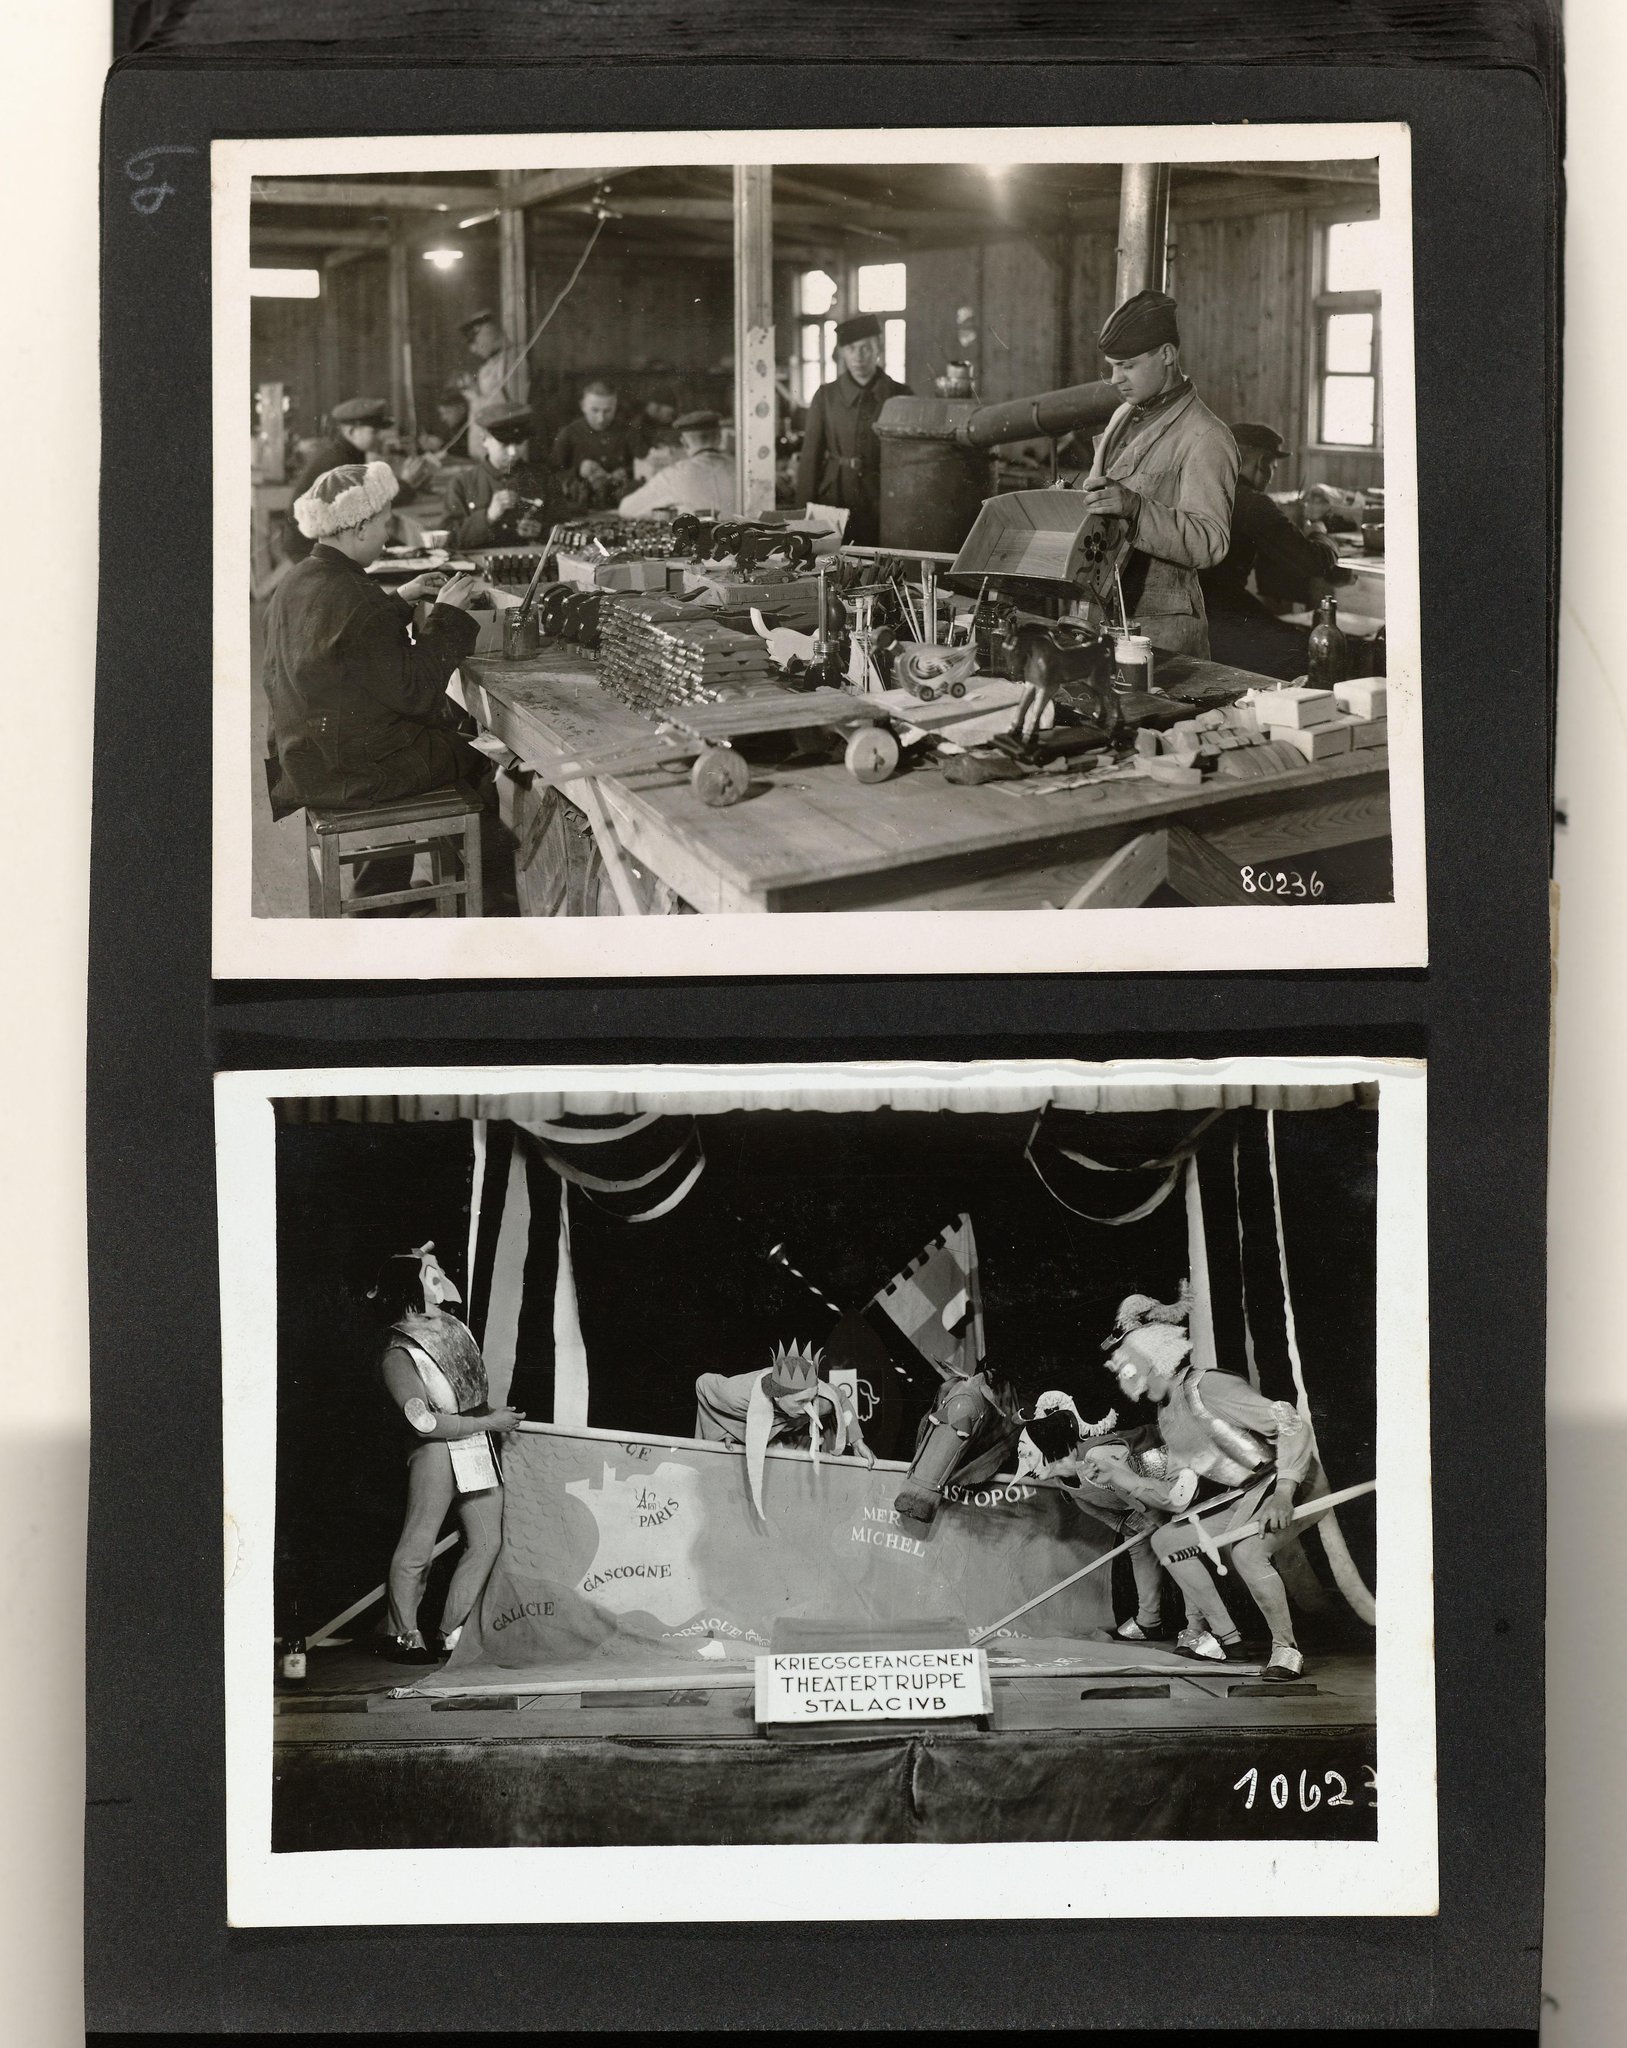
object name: photograph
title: Werkplaats en opvoering van een toneelstuk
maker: dick w.b. van maarseveen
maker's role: fotograaf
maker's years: 1905-1990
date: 1943-1945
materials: cardboard, photographic support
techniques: gelatin silver print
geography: muhlberg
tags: the hague, dick w.b. van maarseveen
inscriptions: inscription: ‘80236’, inscription: ‘10623’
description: Albumblad met twee foto's: een werkplaats een toneelscène op een podium. Onderdeel van een fotoalbum met foto's door Dick van Maarseveen van het krijgsgevangenenkamp Stalag IV B in Mühlberg in de periode 1943-1945.